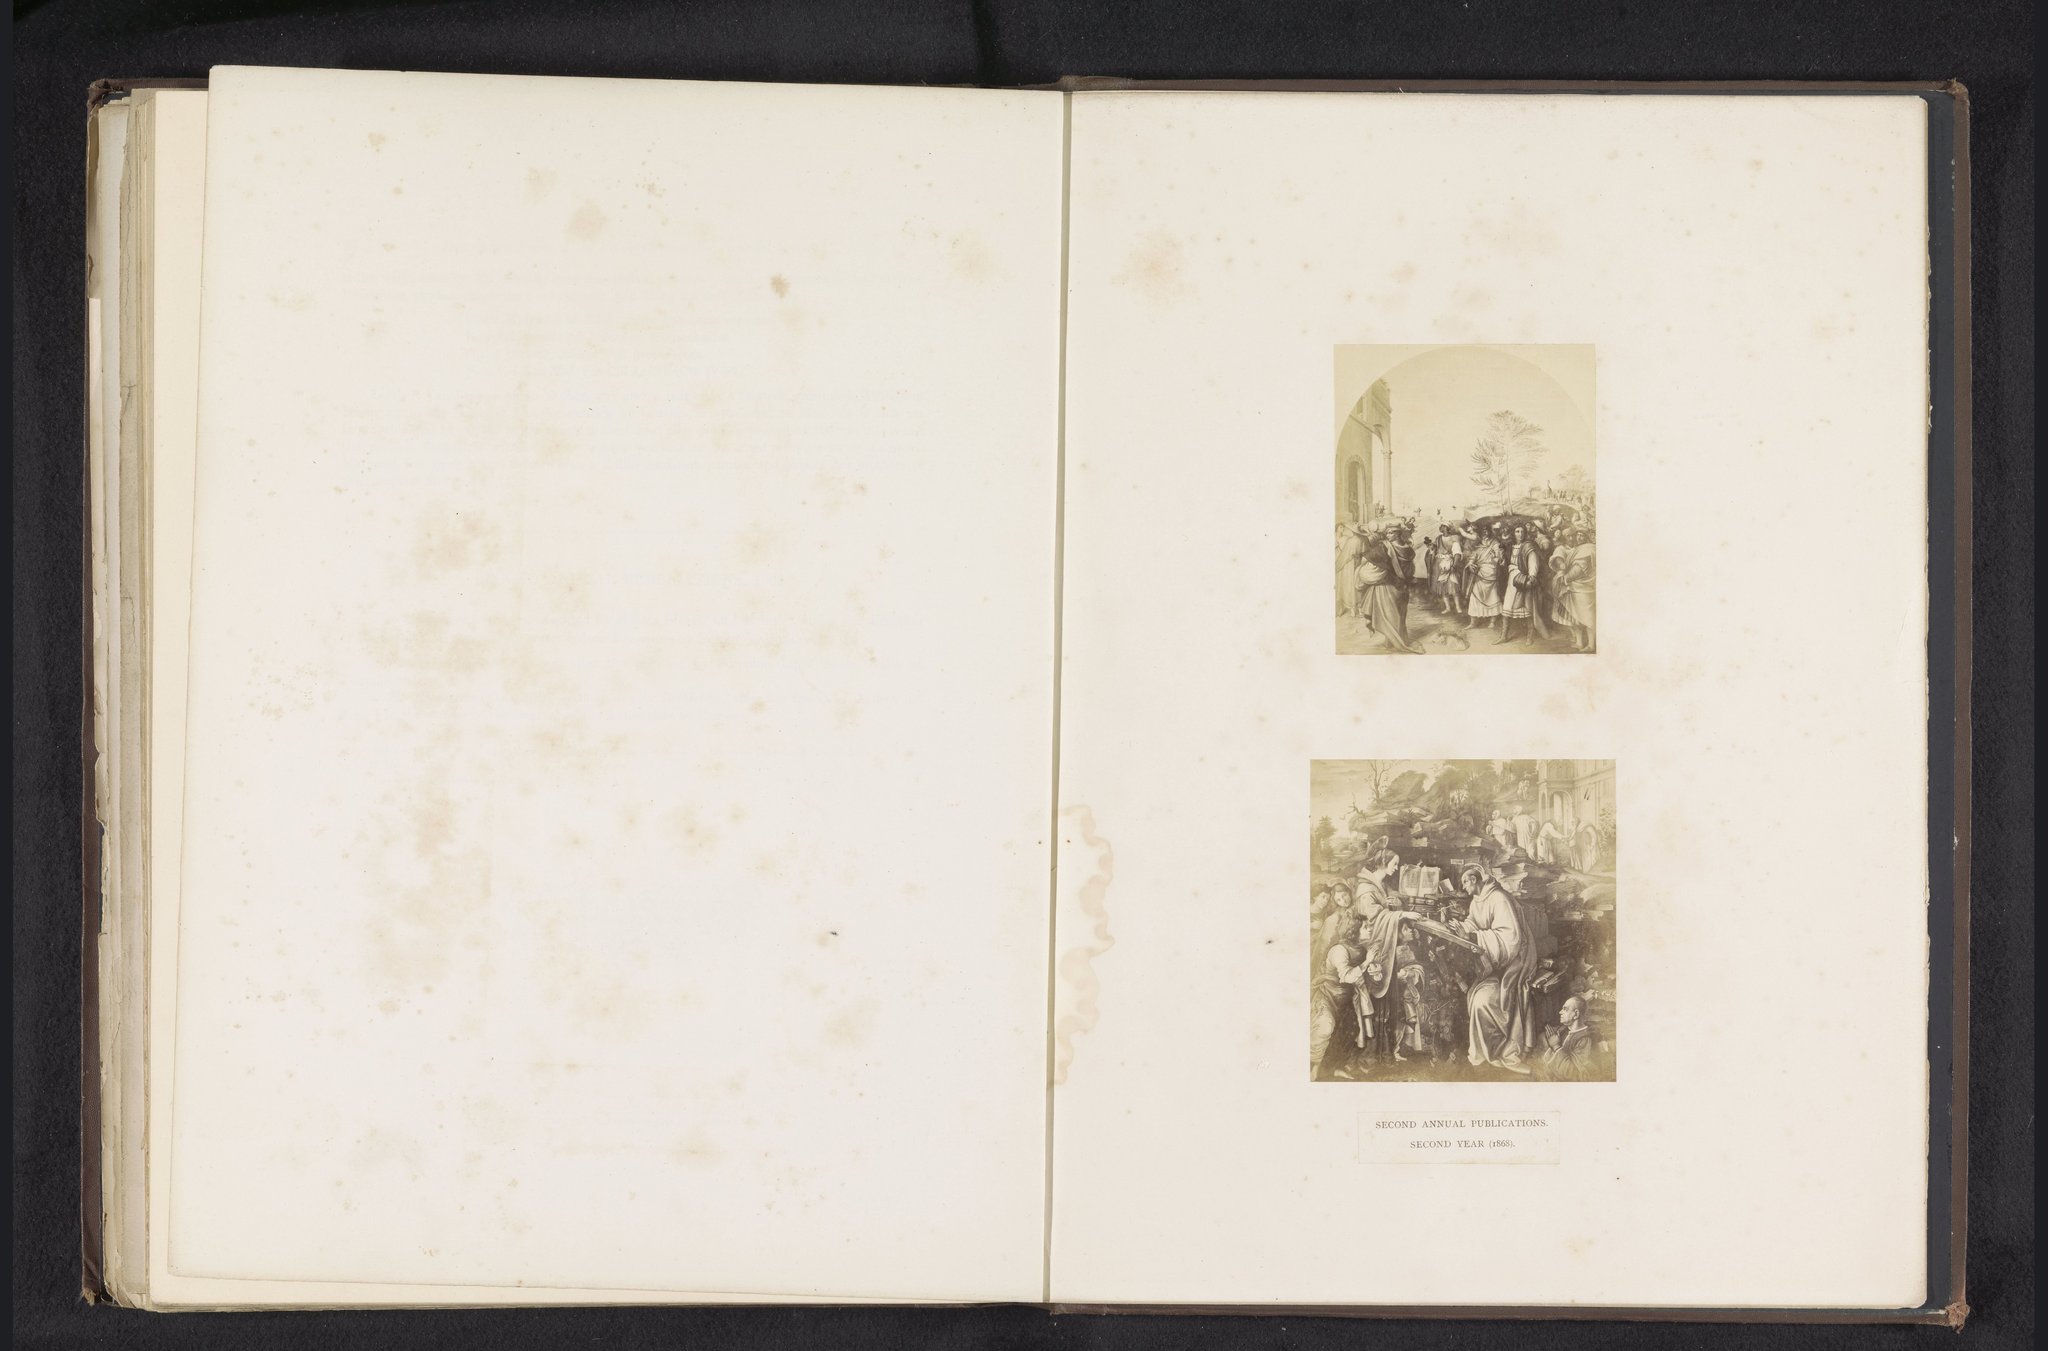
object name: photograph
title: Drie fotoreproducties van een publicatie door de Arundel Society met schilderijen van Jan van Eyck en Masaccio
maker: Anonymous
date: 1859-1869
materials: photographic support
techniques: albumen print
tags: book, painting (including book-illumination, miniature-painting)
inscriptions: inscription: ‘first annual publications. twentieth year (1868).’